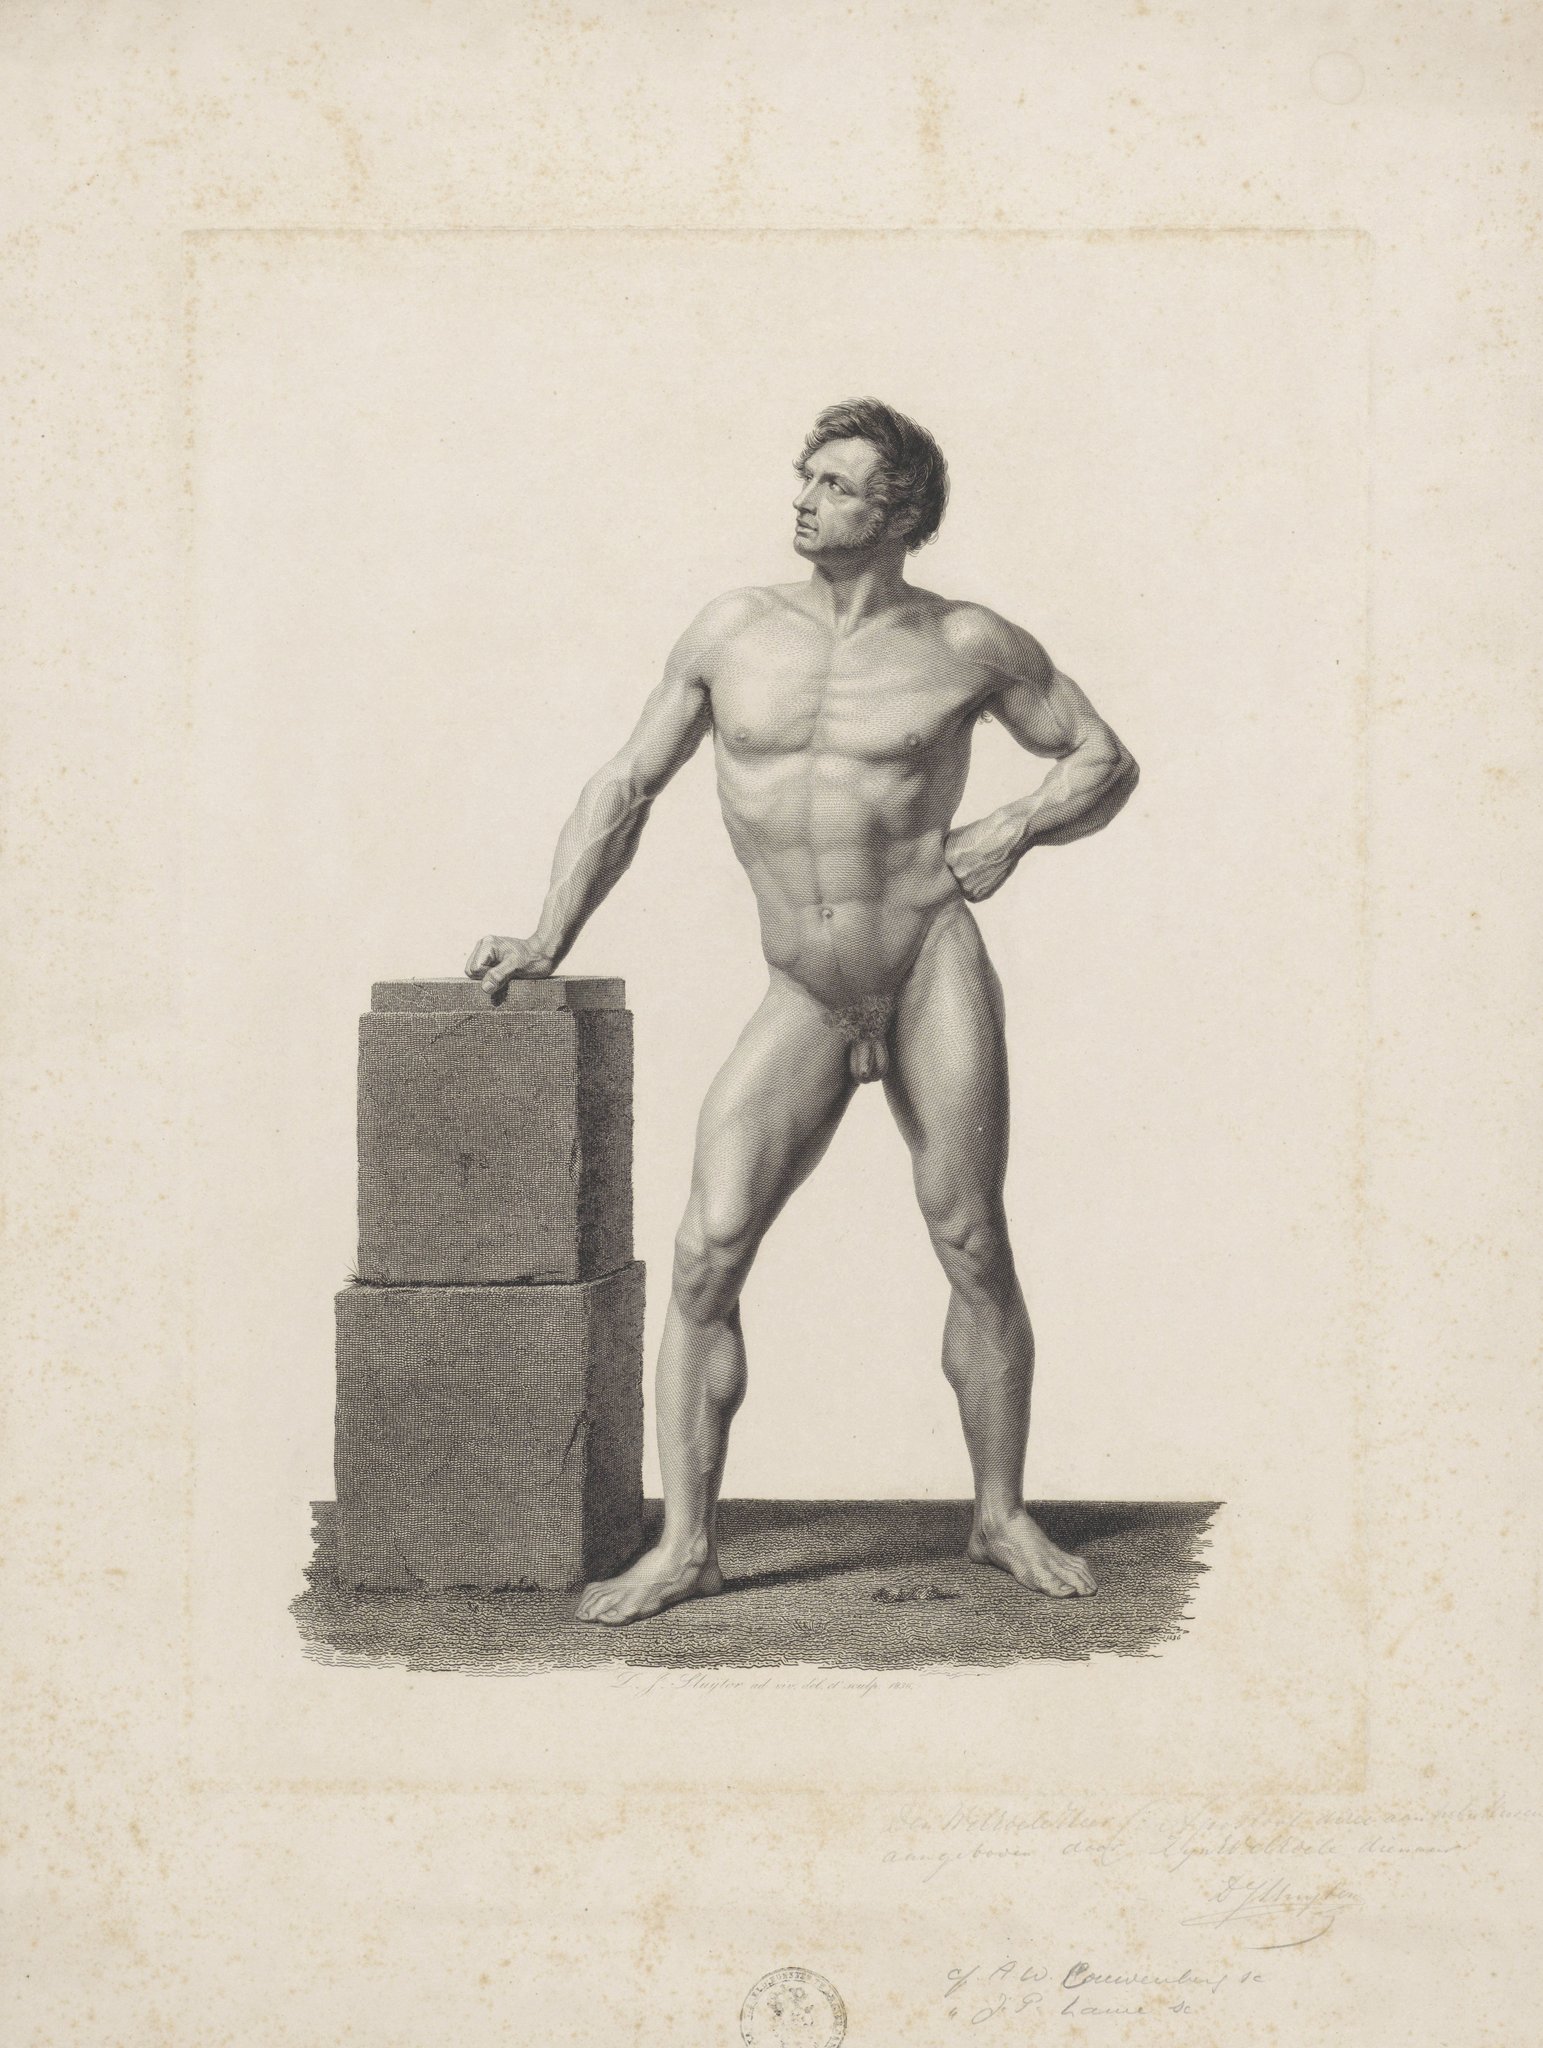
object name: print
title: Staand mannelijk naakt bij stenen blok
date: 1836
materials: paper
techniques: engraving, etching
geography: amsterdam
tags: human figure of ideal proportions, e.g. academic nude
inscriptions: inscription: ‘Den Weledele Heer C. Apostool dirct. aan het Museum aangeboden door zijn weledele dienaar D.J. Sluyter.’, collector's mark: Lugt 2228, collector's mark: Lugt 10, inscription: ‘cf. A.W. Couwenberg sc. / cf. J.P. Lame sc.’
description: Amsterdamse Academiestudie van een staande naakte man, die met een arm op een stenen blok steunt.